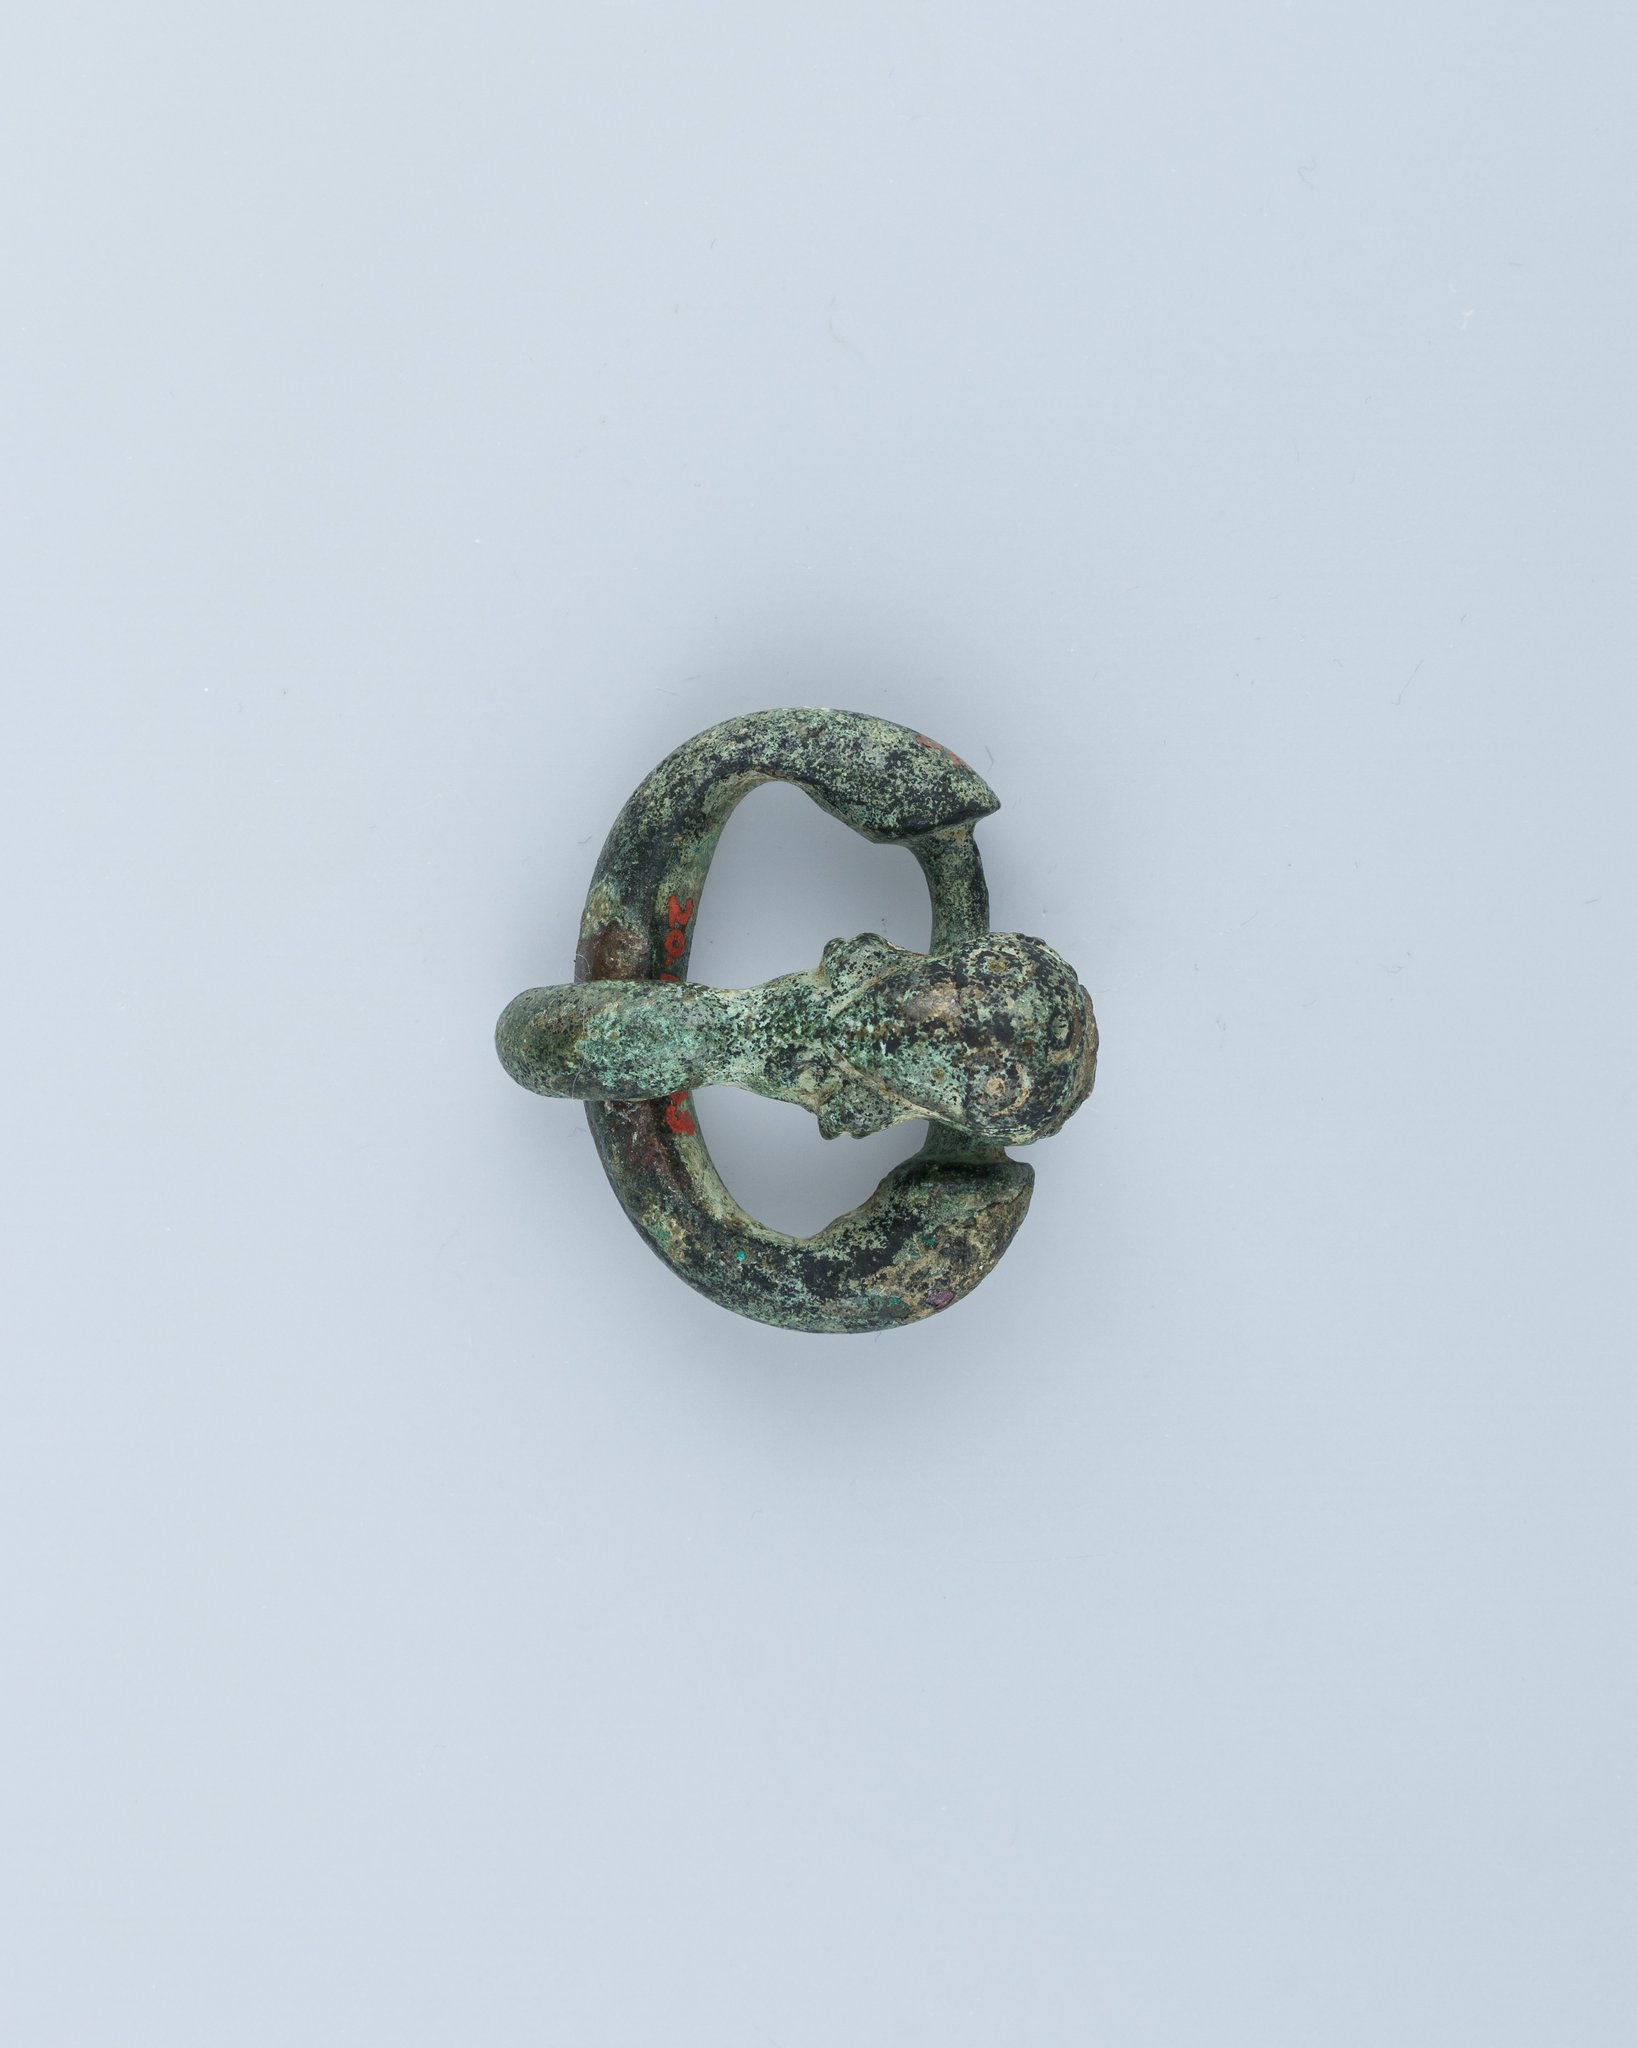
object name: buckle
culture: lombard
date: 501-800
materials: bronze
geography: italy